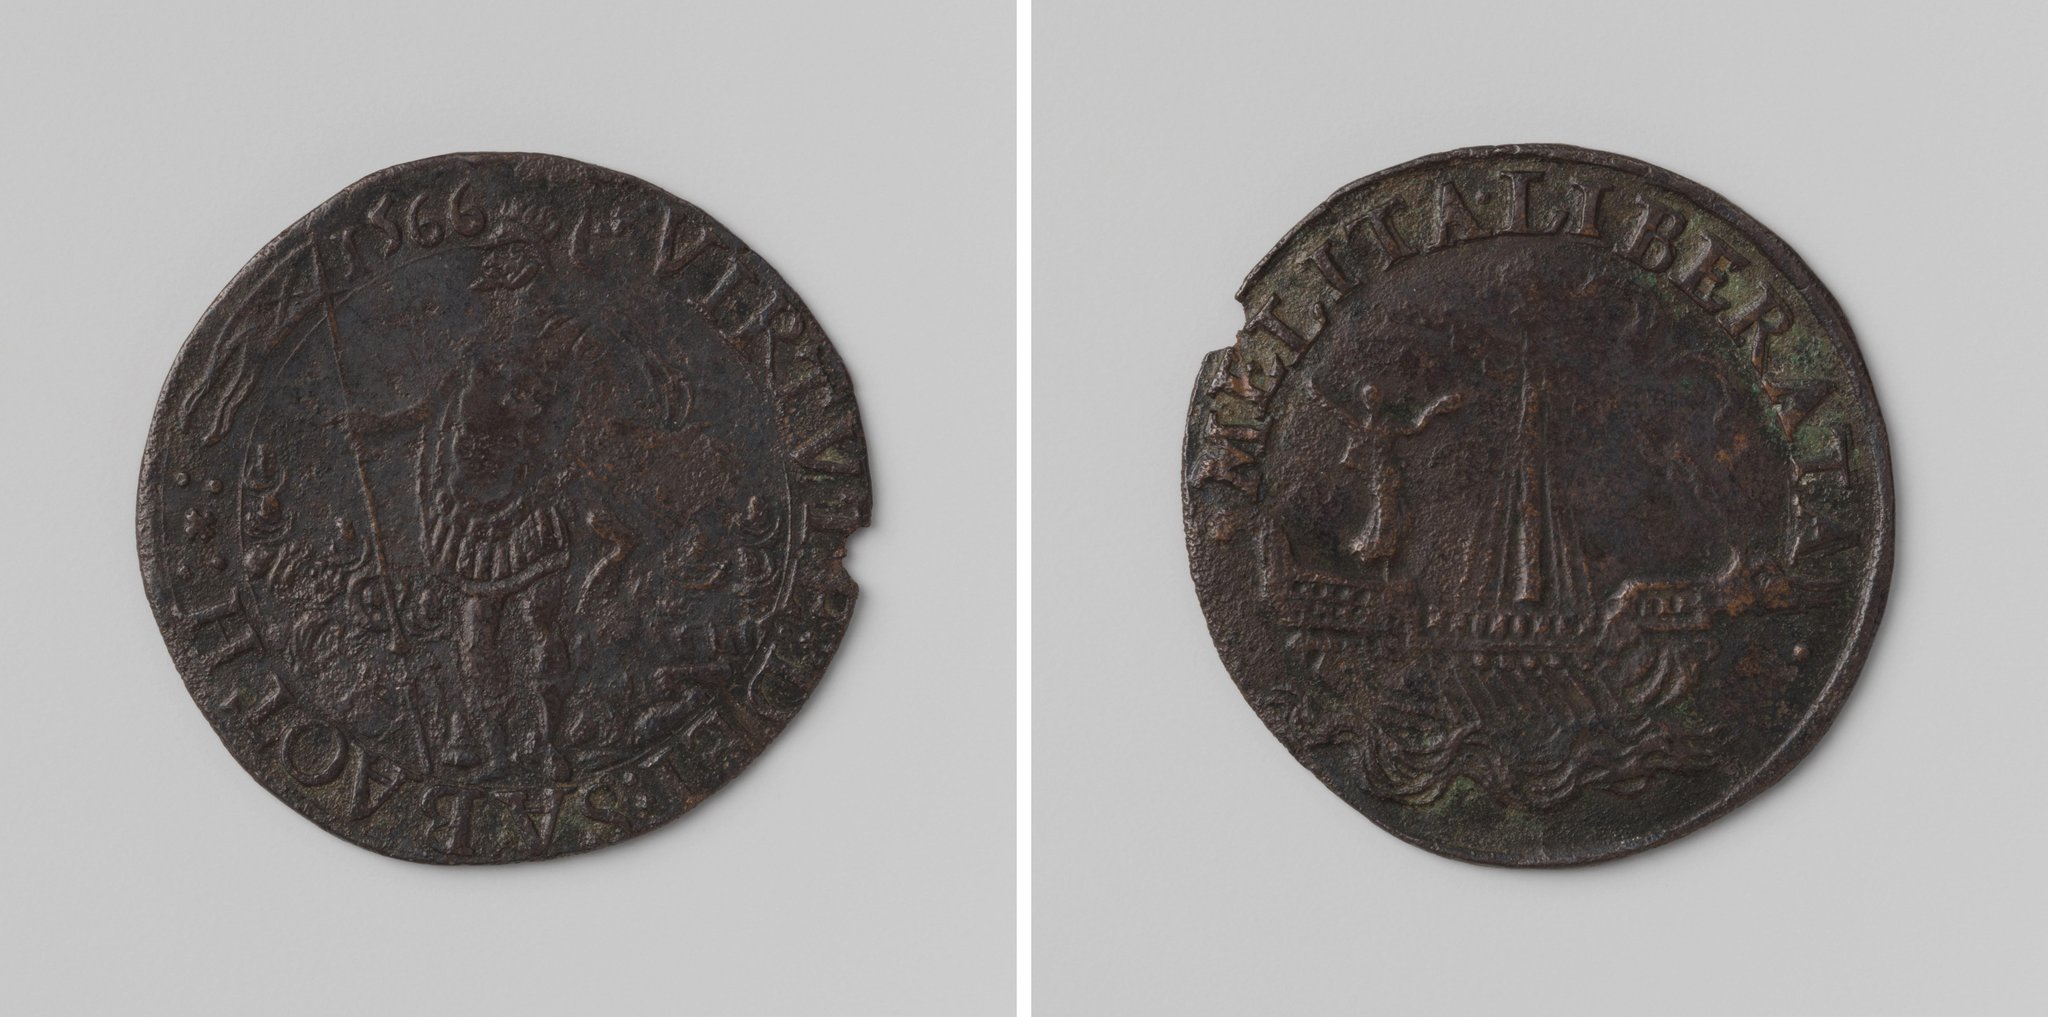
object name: jeton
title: De Turken van Malta verdreven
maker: Anonymous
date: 1566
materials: copper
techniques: striking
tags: malta, oorlog van turken tegen heilige roomse rijk, ontzet van malta (1565)